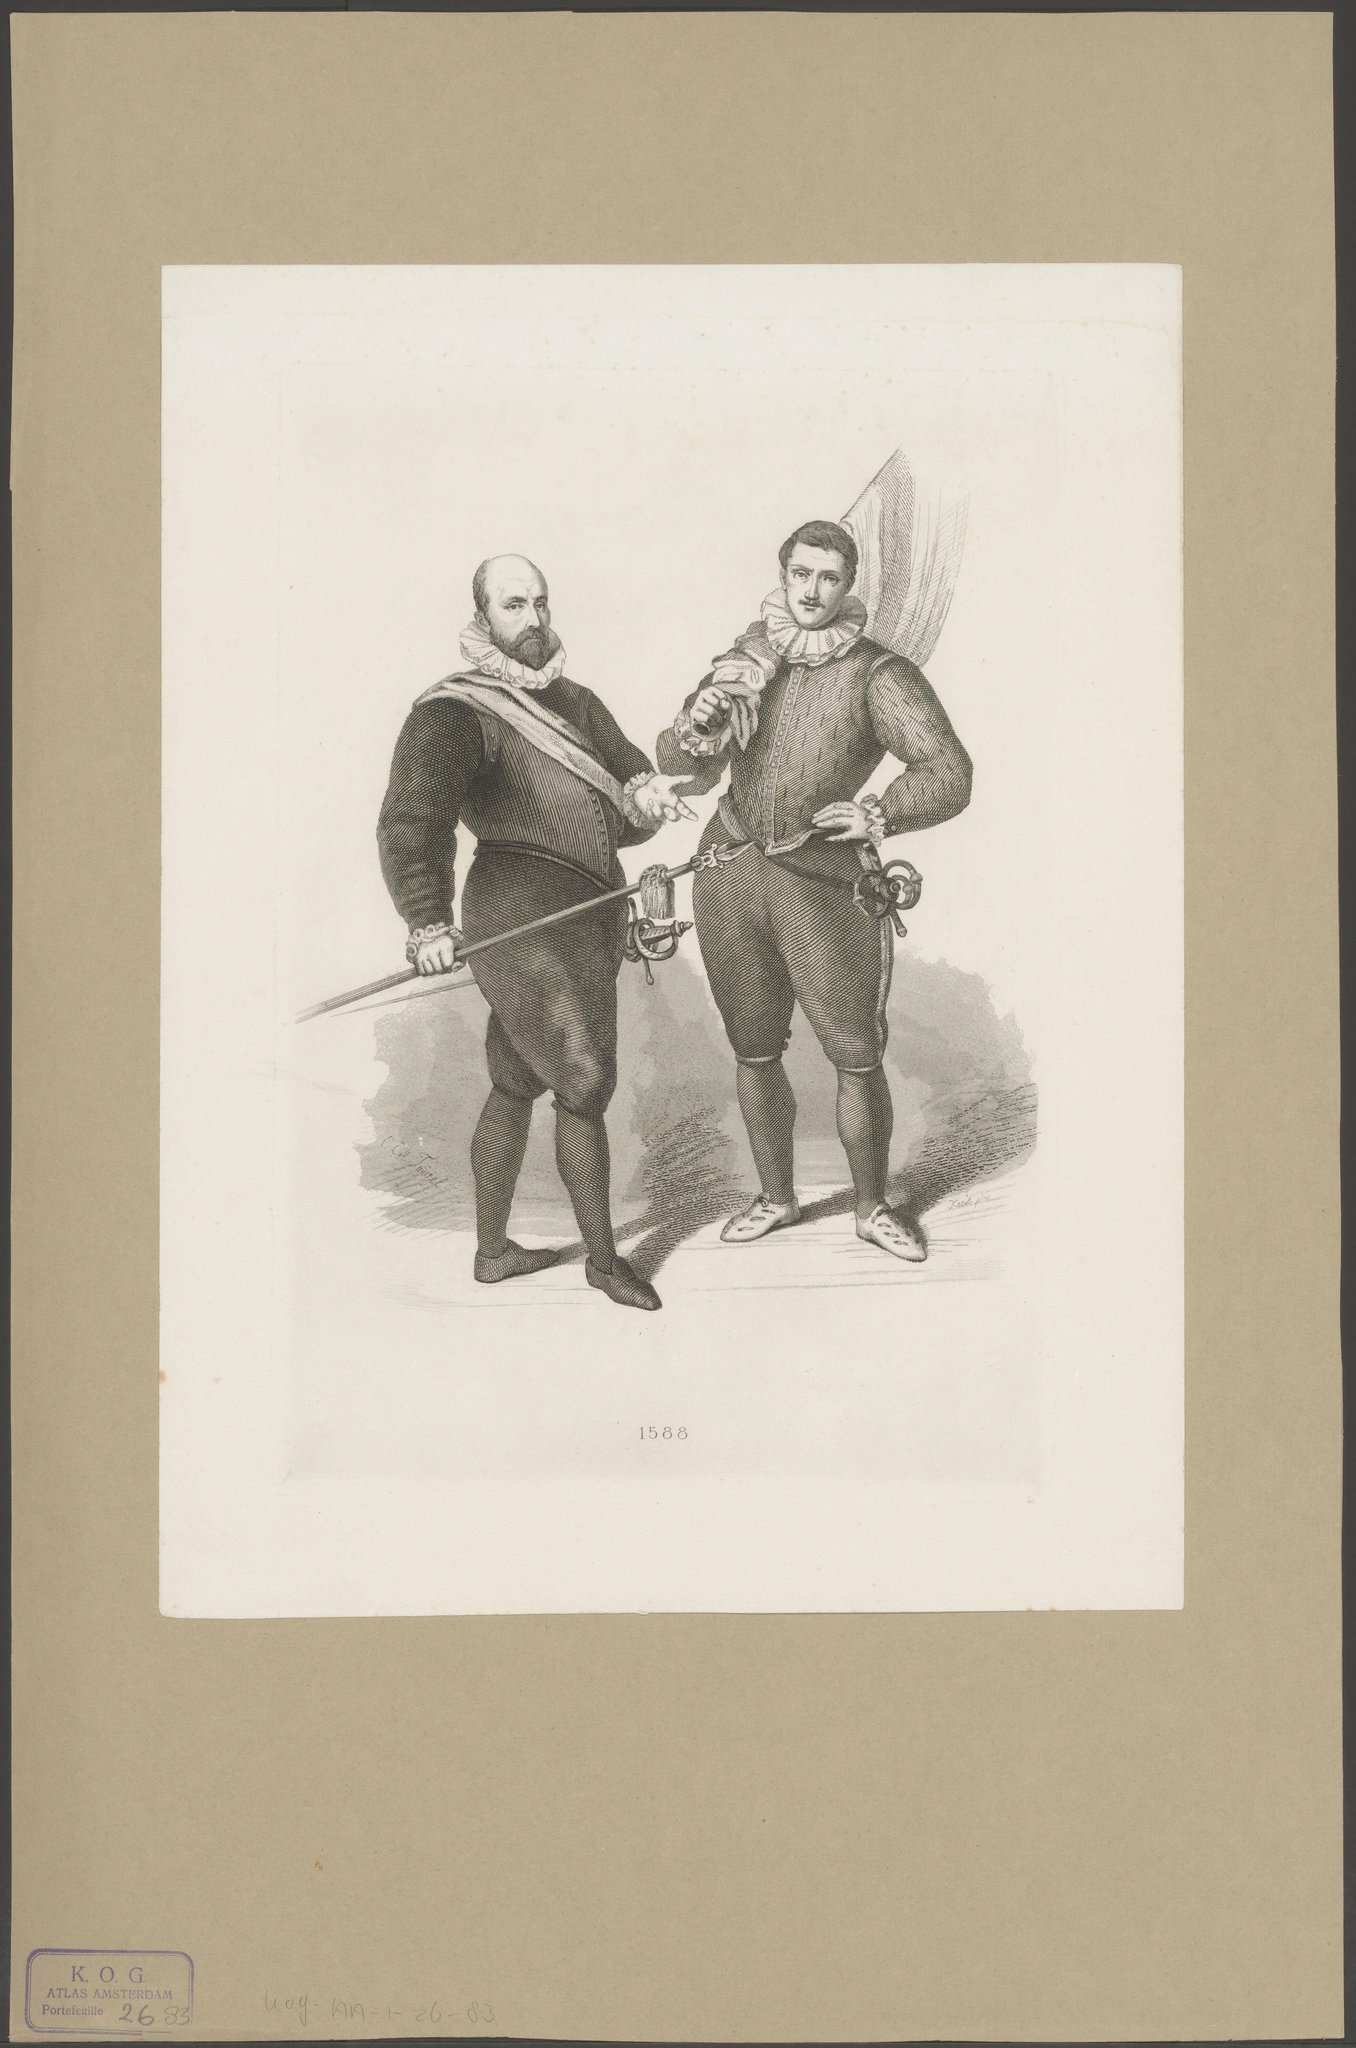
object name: print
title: 1588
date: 1874-1875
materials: paper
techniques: engraving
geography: utrecht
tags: historical persons, helved weapons, polearms (for striking, hacking, thrusting): lance, (military) standard-bearer, amsterdam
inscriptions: collector's mark: Lugt 1641b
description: Prent mogelijk uit: Hofdijk, Willem Jacobsz. De oude schutterij in Nederland. Amsterdam: Reinier Willem Petrus de Vries, 1874. Of uit: Hofdijk, Willem Jacobsz. De oude schutterij in Nederland. Utrecht: Kemink & Zoon, 1875.